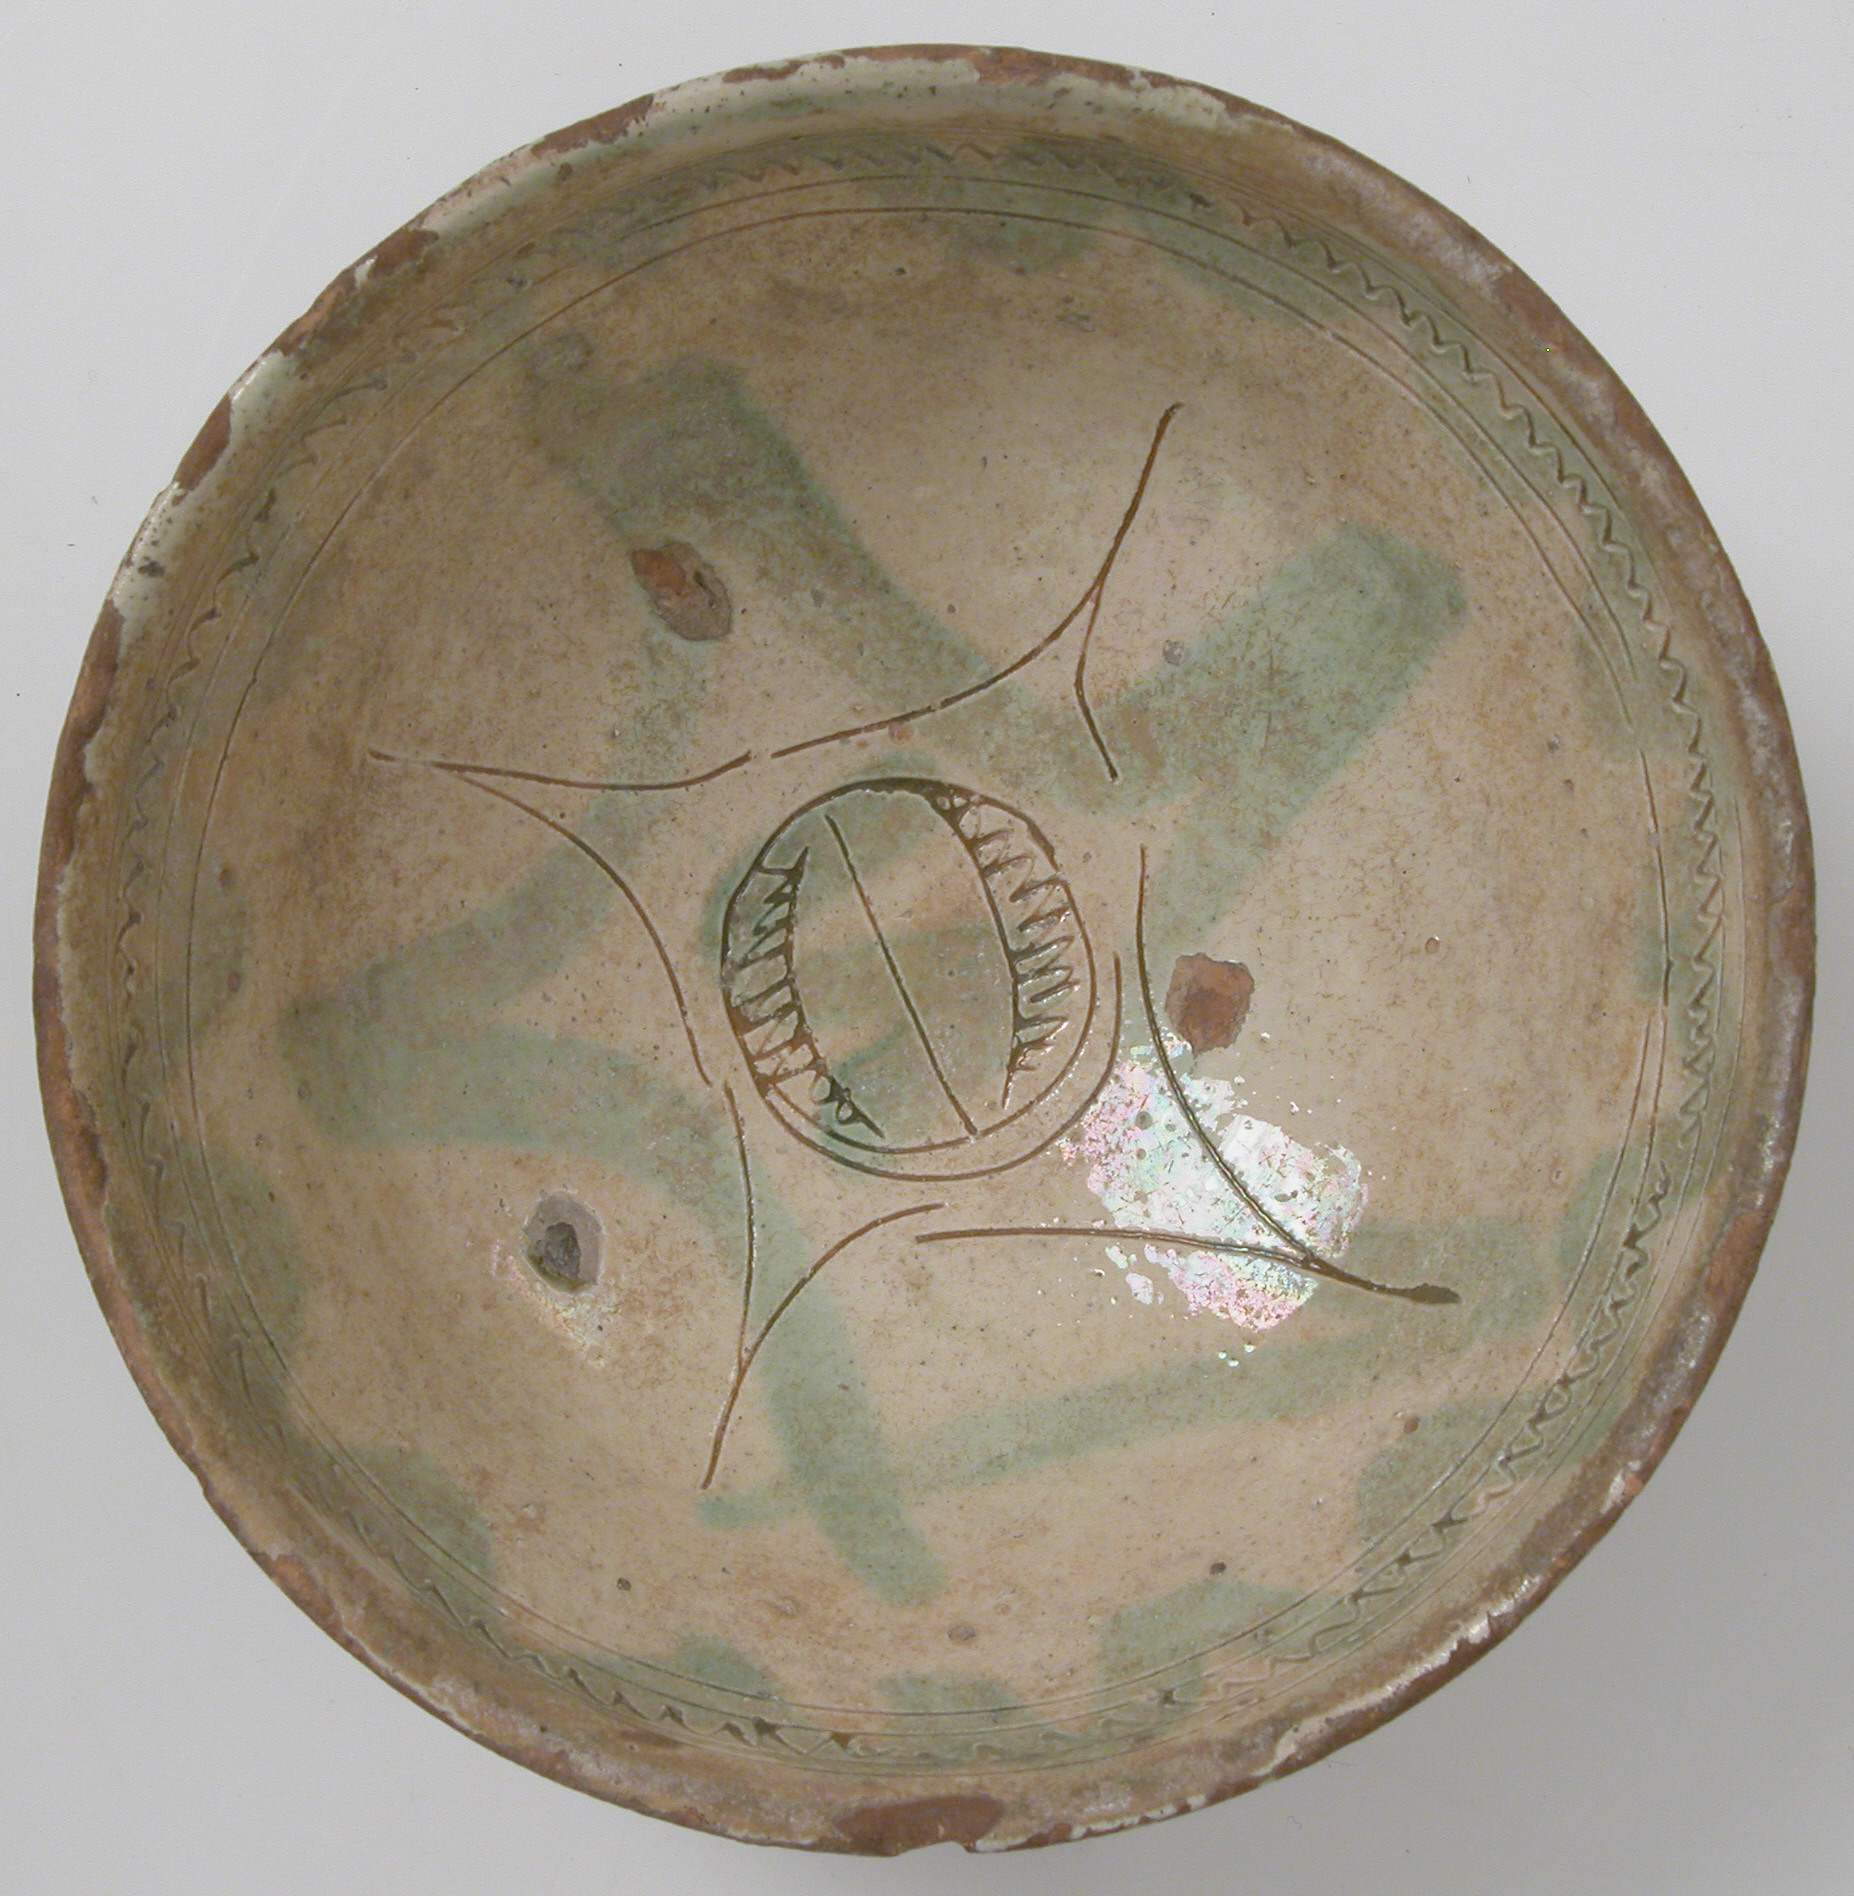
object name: bowl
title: Cup with Star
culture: byzantine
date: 1501-1600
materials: earthenware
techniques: glazing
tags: stars